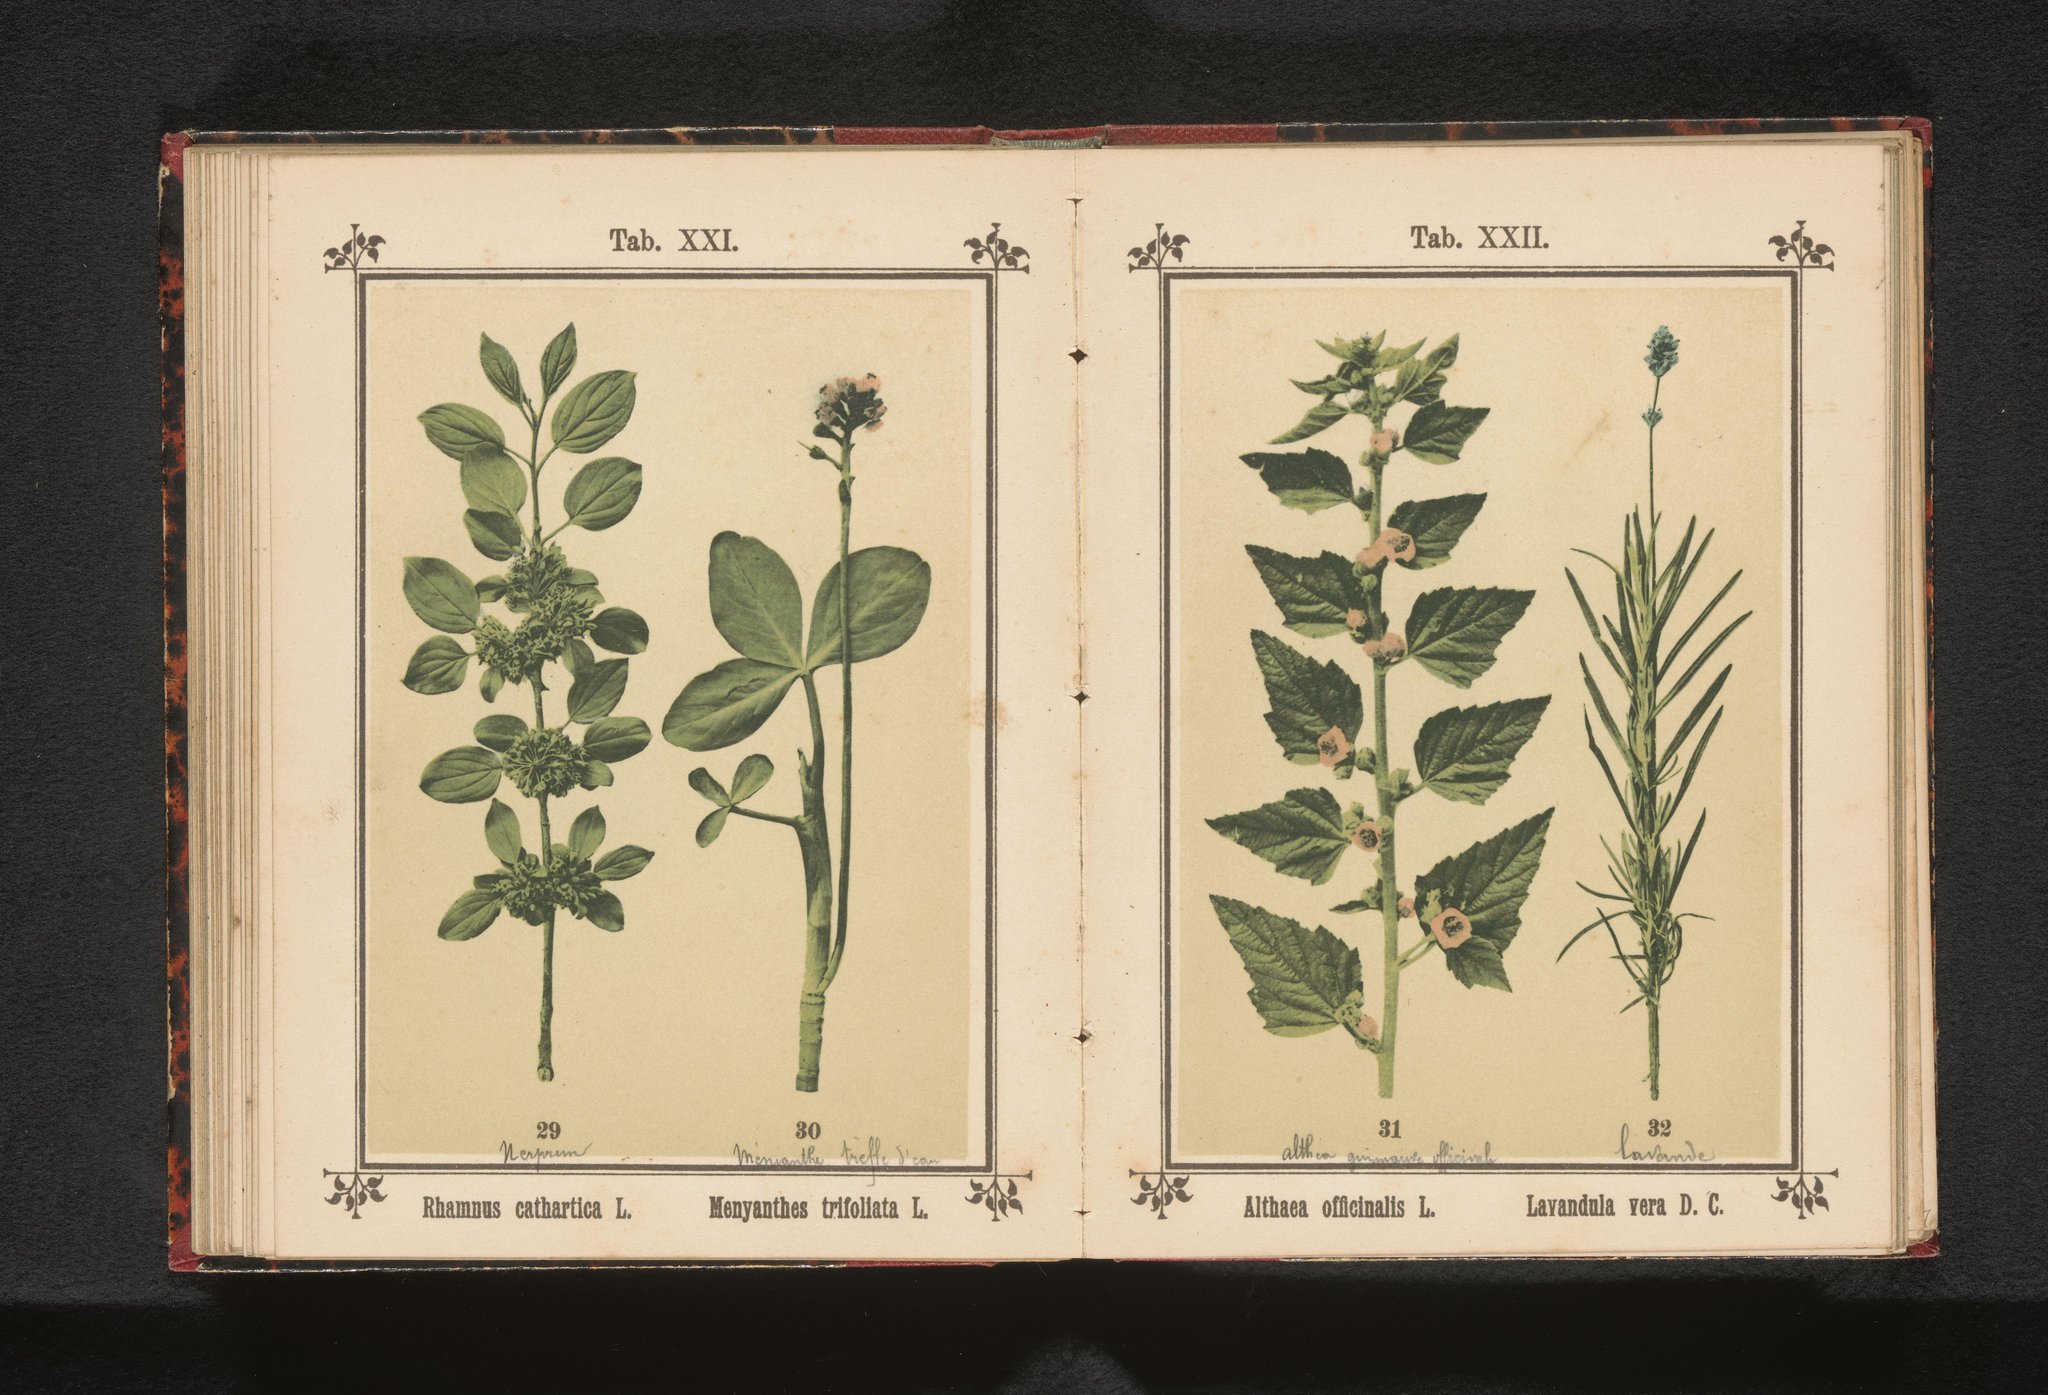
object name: photomechanical print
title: Wegedoorn en waterdrieblad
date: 1884-1894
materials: paper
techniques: photograph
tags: plants and herbs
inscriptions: inscription: ‘Nerprun menianthe trèfle d'eau’, number: ‘Tab. XXI.’